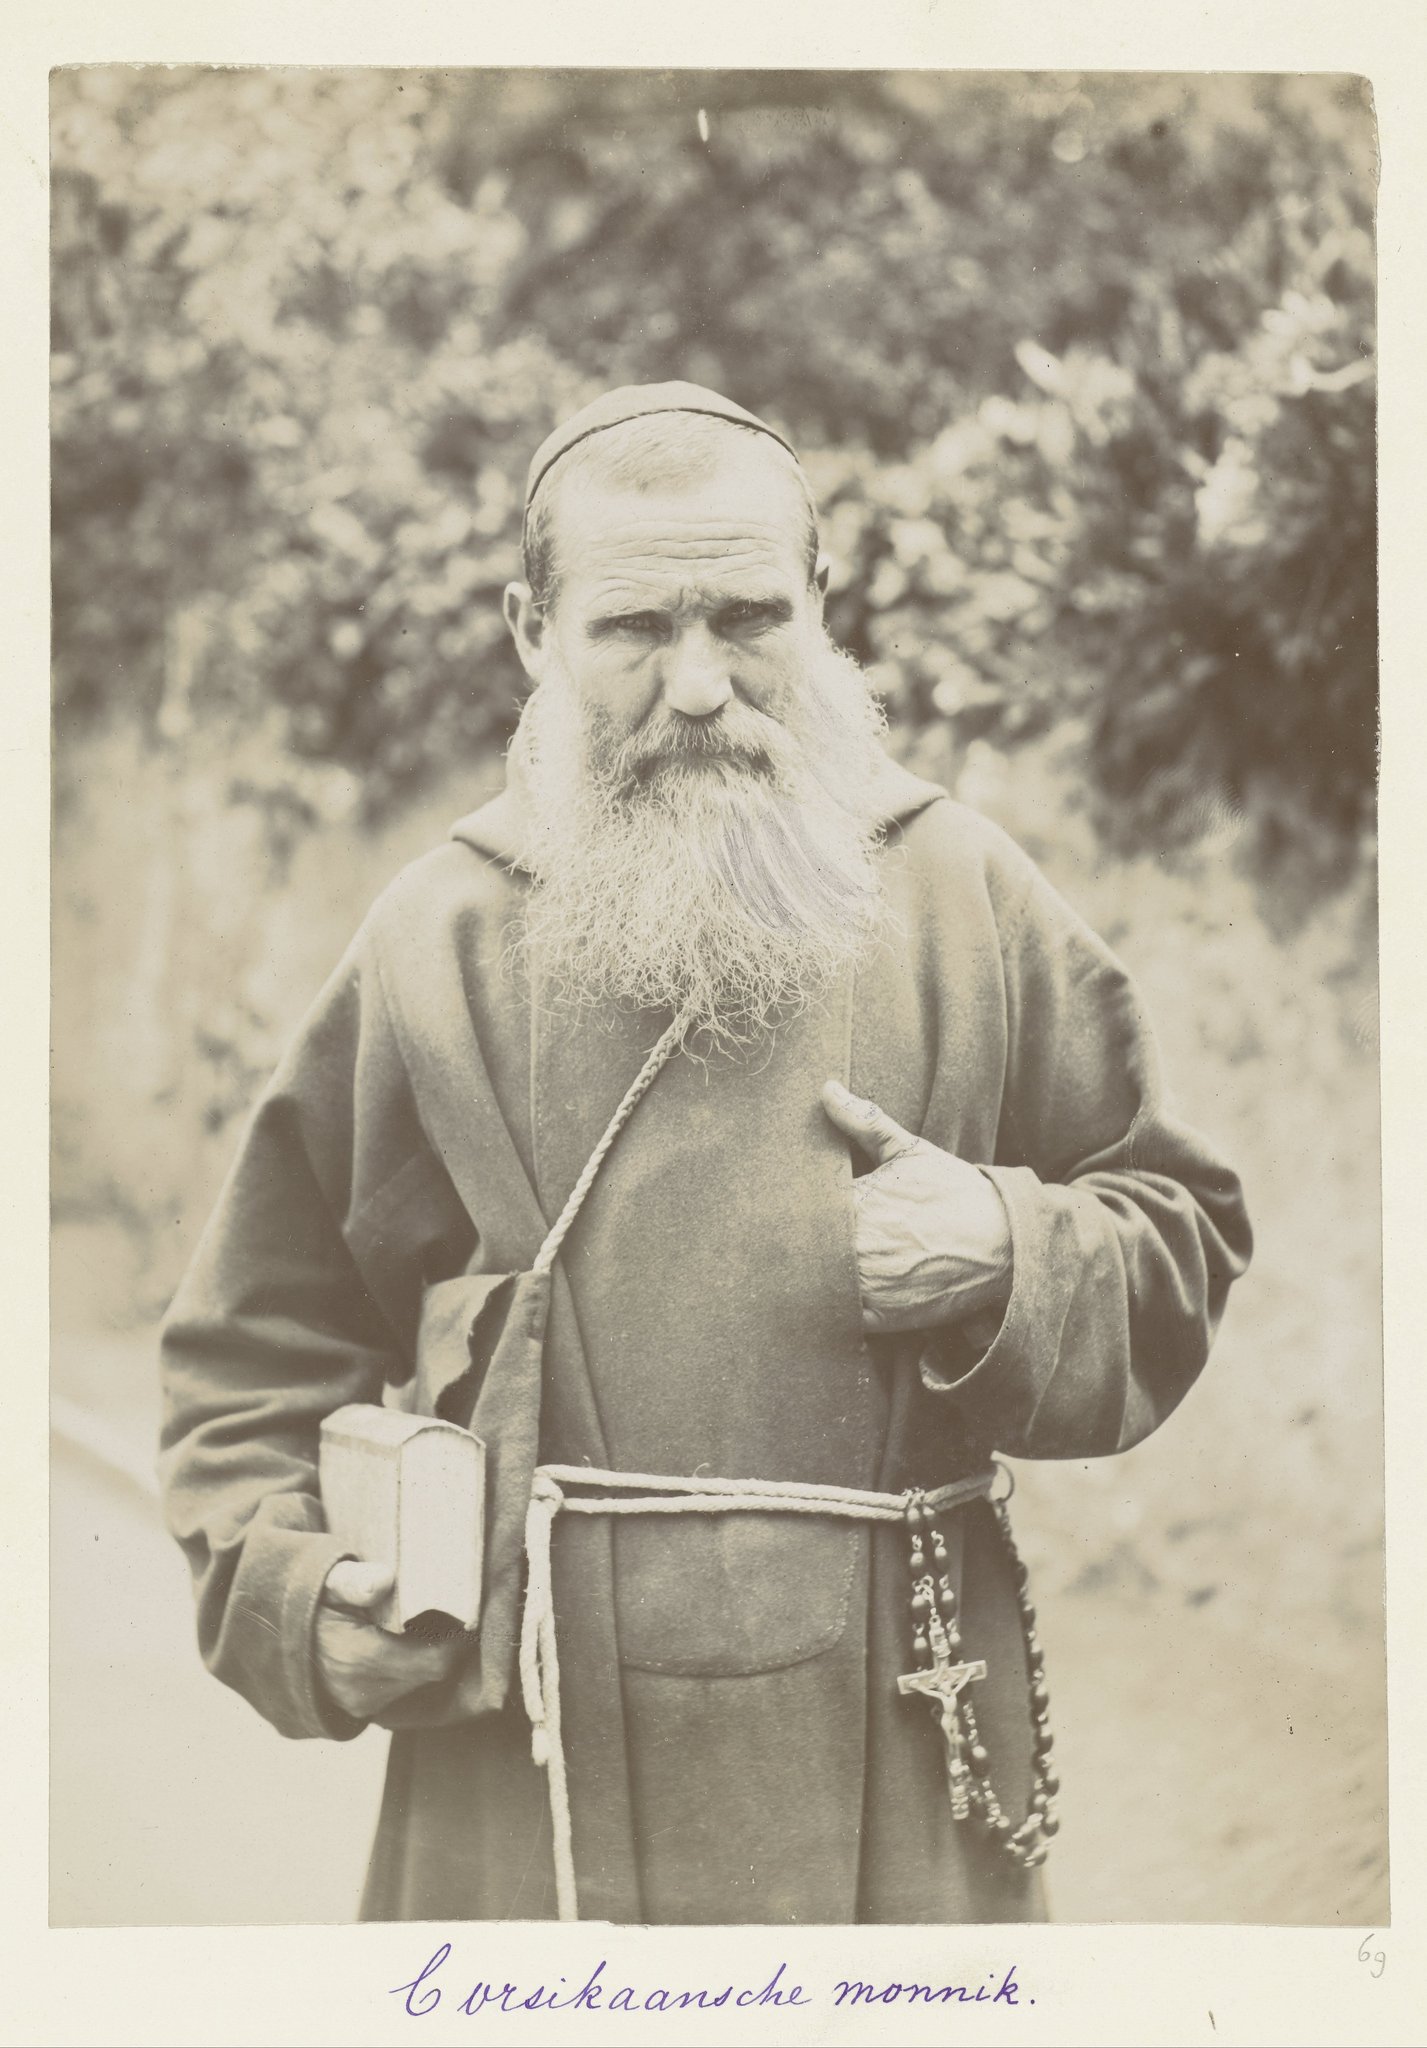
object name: photograph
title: Portret van een monnik in pij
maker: henry pauw van wieldrecht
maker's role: fotograaf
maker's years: 1863-1912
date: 1886-1896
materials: cardboard, photographic support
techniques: albumen print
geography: corsica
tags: corsica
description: Een monnik in pij met een boek in zijn hand.